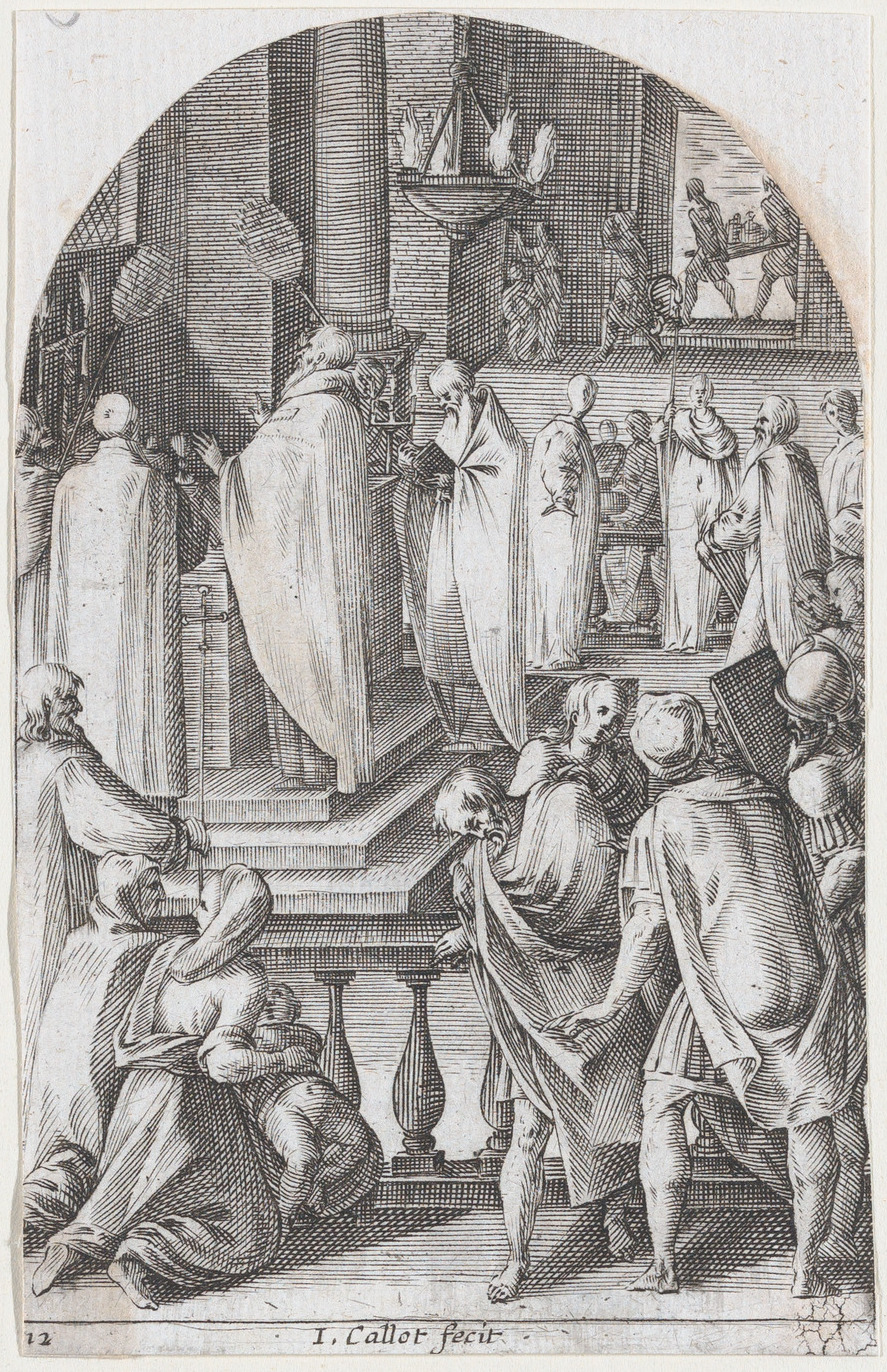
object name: print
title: St. Basil Celebrating the Sacrifice of the Mass [The Celebration of the Holy Mysteries], plate 12 from "Les Tableaux de Rome, Les Eglises Jubilaires" (The Paintings of Rome, The Churches Jubilee)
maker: jacques callot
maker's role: artist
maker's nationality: french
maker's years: 1592-1635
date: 1607-1611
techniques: engraving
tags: men,women,saints